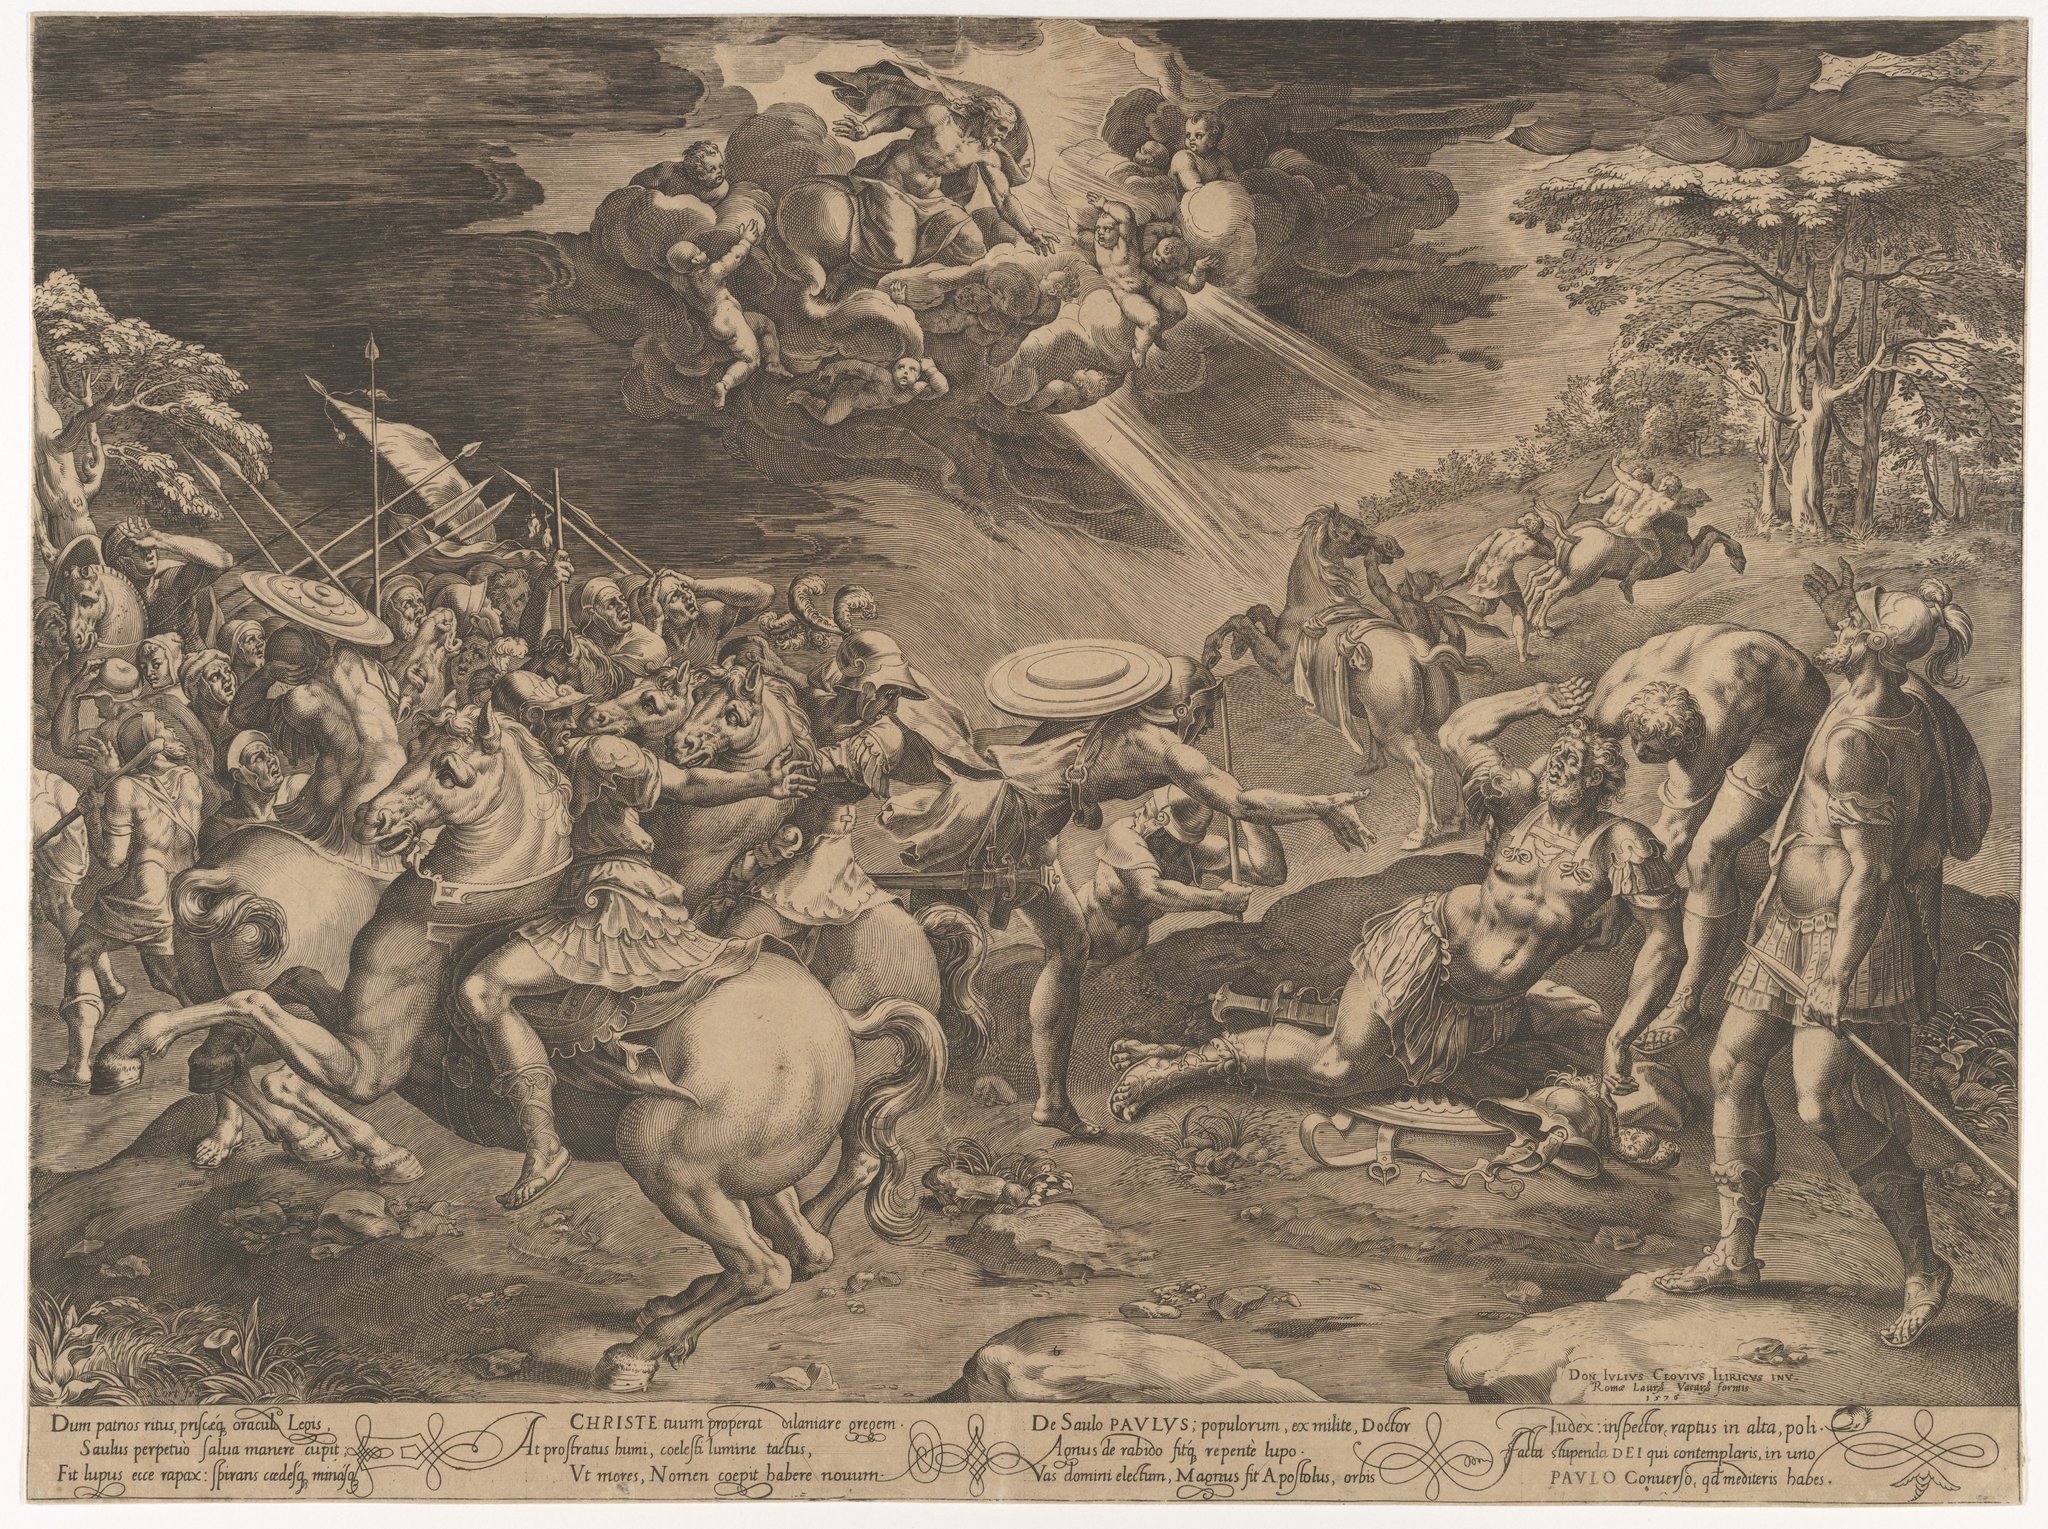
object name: print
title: The Conversion of Saint Paul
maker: cornelis cort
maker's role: artist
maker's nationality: netherlandish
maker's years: 1533-1578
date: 1576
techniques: engraving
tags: soldiers,horses,saint paul